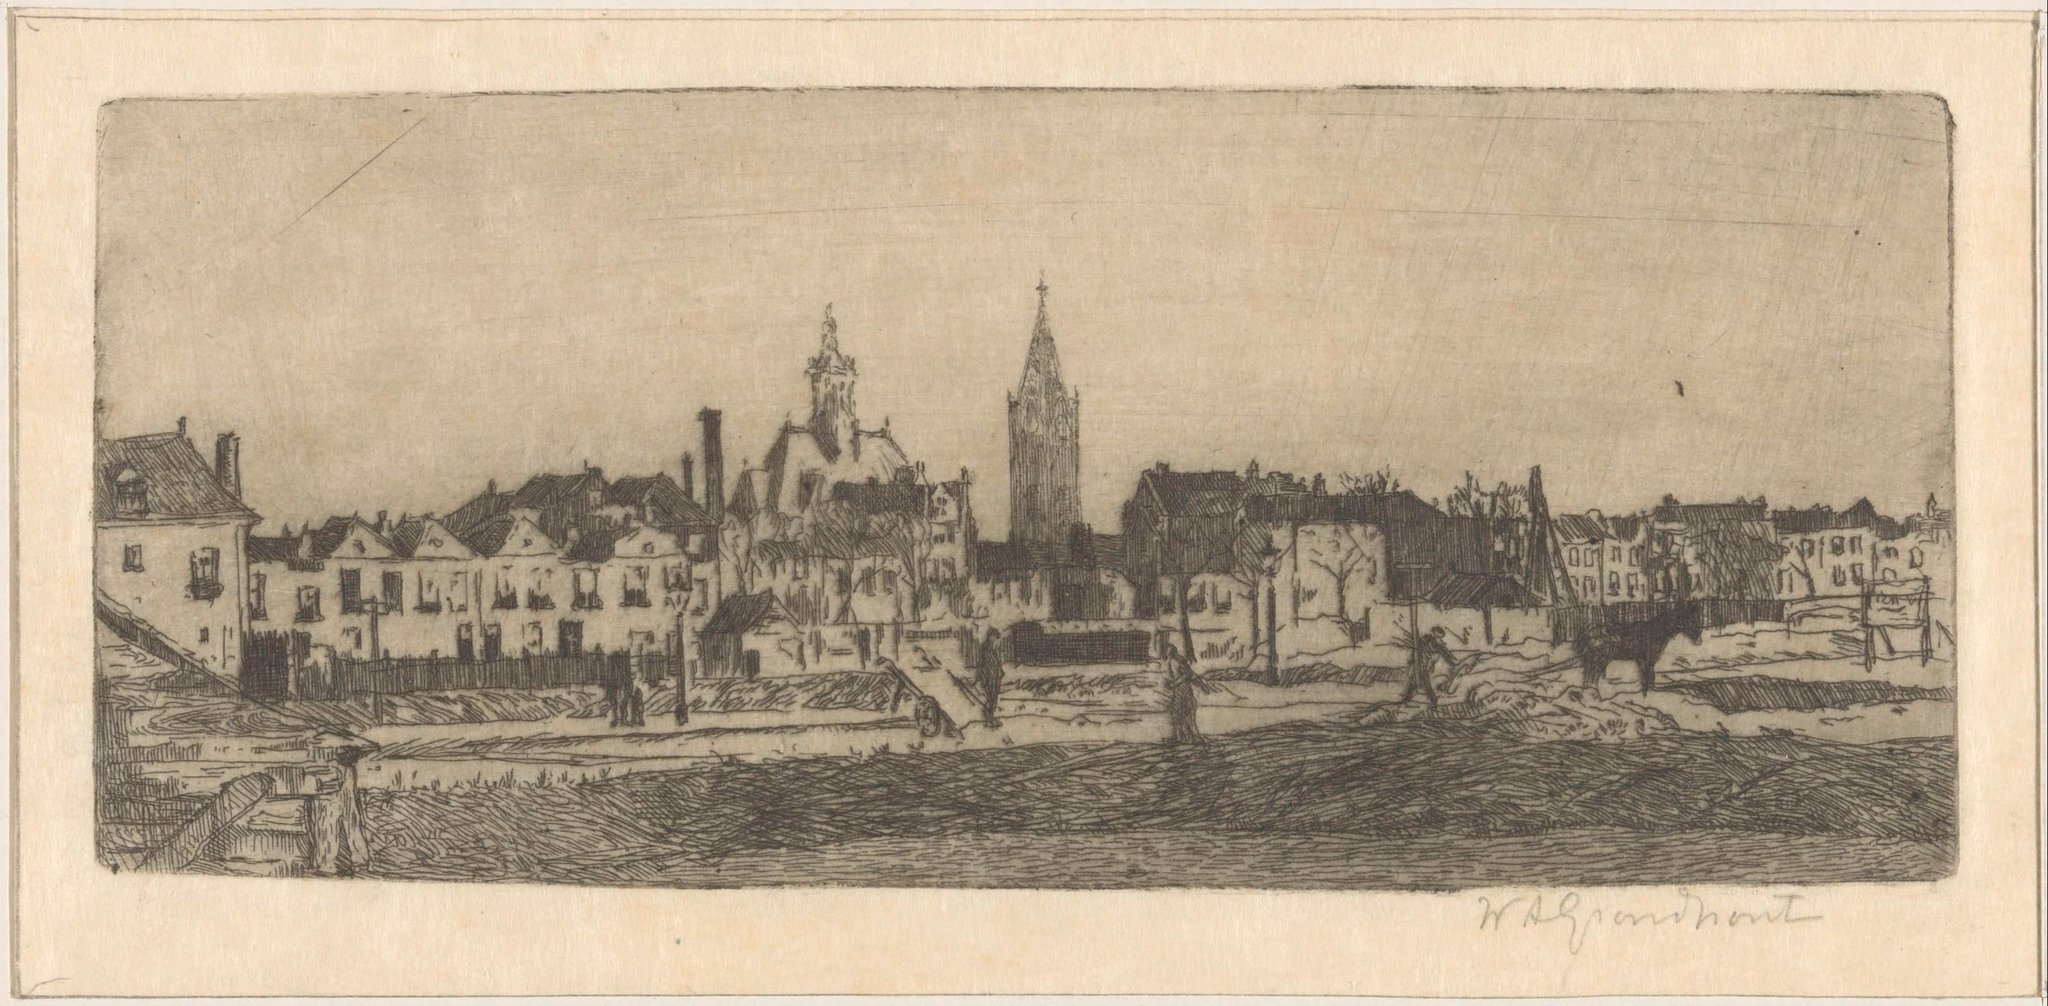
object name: print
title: Delft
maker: willem adrianus grondhout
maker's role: draughtsman, painter, print maker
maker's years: 1878-1934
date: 1888-1934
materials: paper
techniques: etching, intaglio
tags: city-view, and landscape with man-made constructions, delft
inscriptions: collector's mark: Lugt 2228